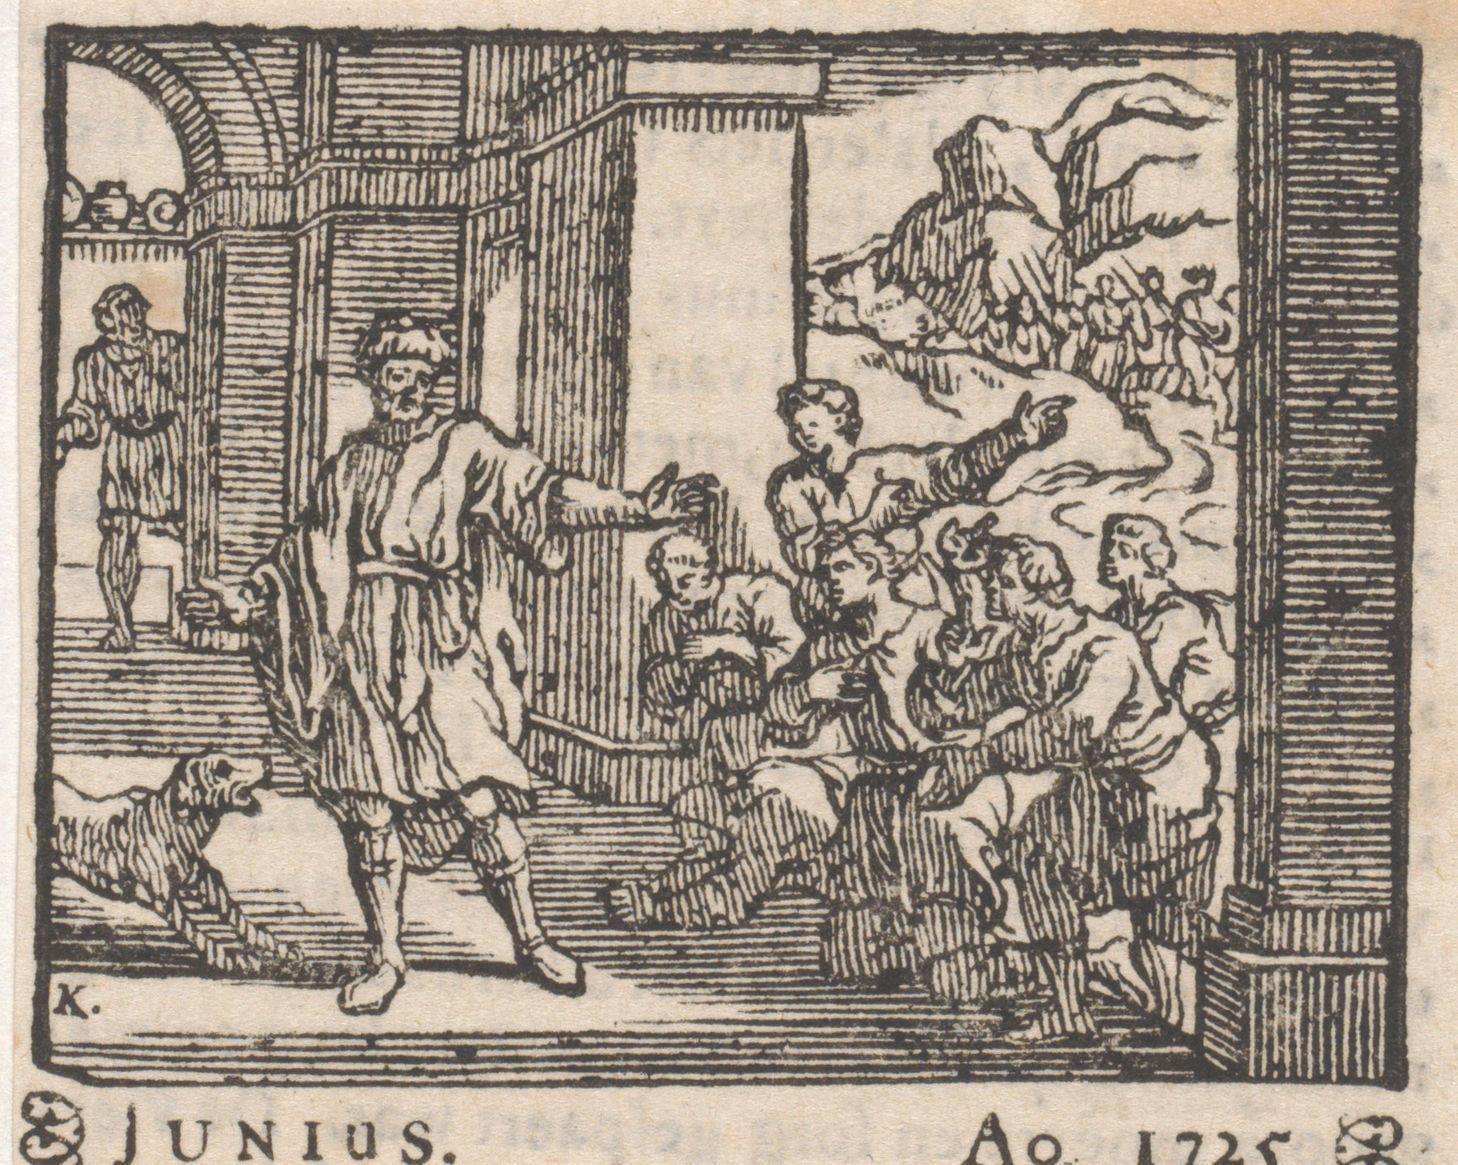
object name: print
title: Volk knielt voor één van de apostelen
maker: jan lauwryn krafft (i)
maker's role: print maker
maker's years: 1694-1785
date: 1725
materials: paper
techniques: letterpress printing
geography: southern netherlands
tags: lives and acts of the apostles of christ; epistles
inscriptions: collector's mark: Lugt 2228